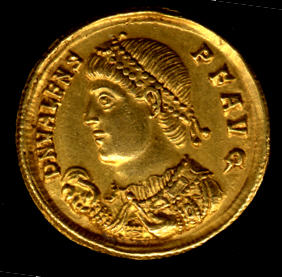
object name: solidus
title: Gold Solidus of Valens (364–78)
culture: byzantine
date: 364-378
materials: gold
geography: constantinople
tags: emperors,men,profiles